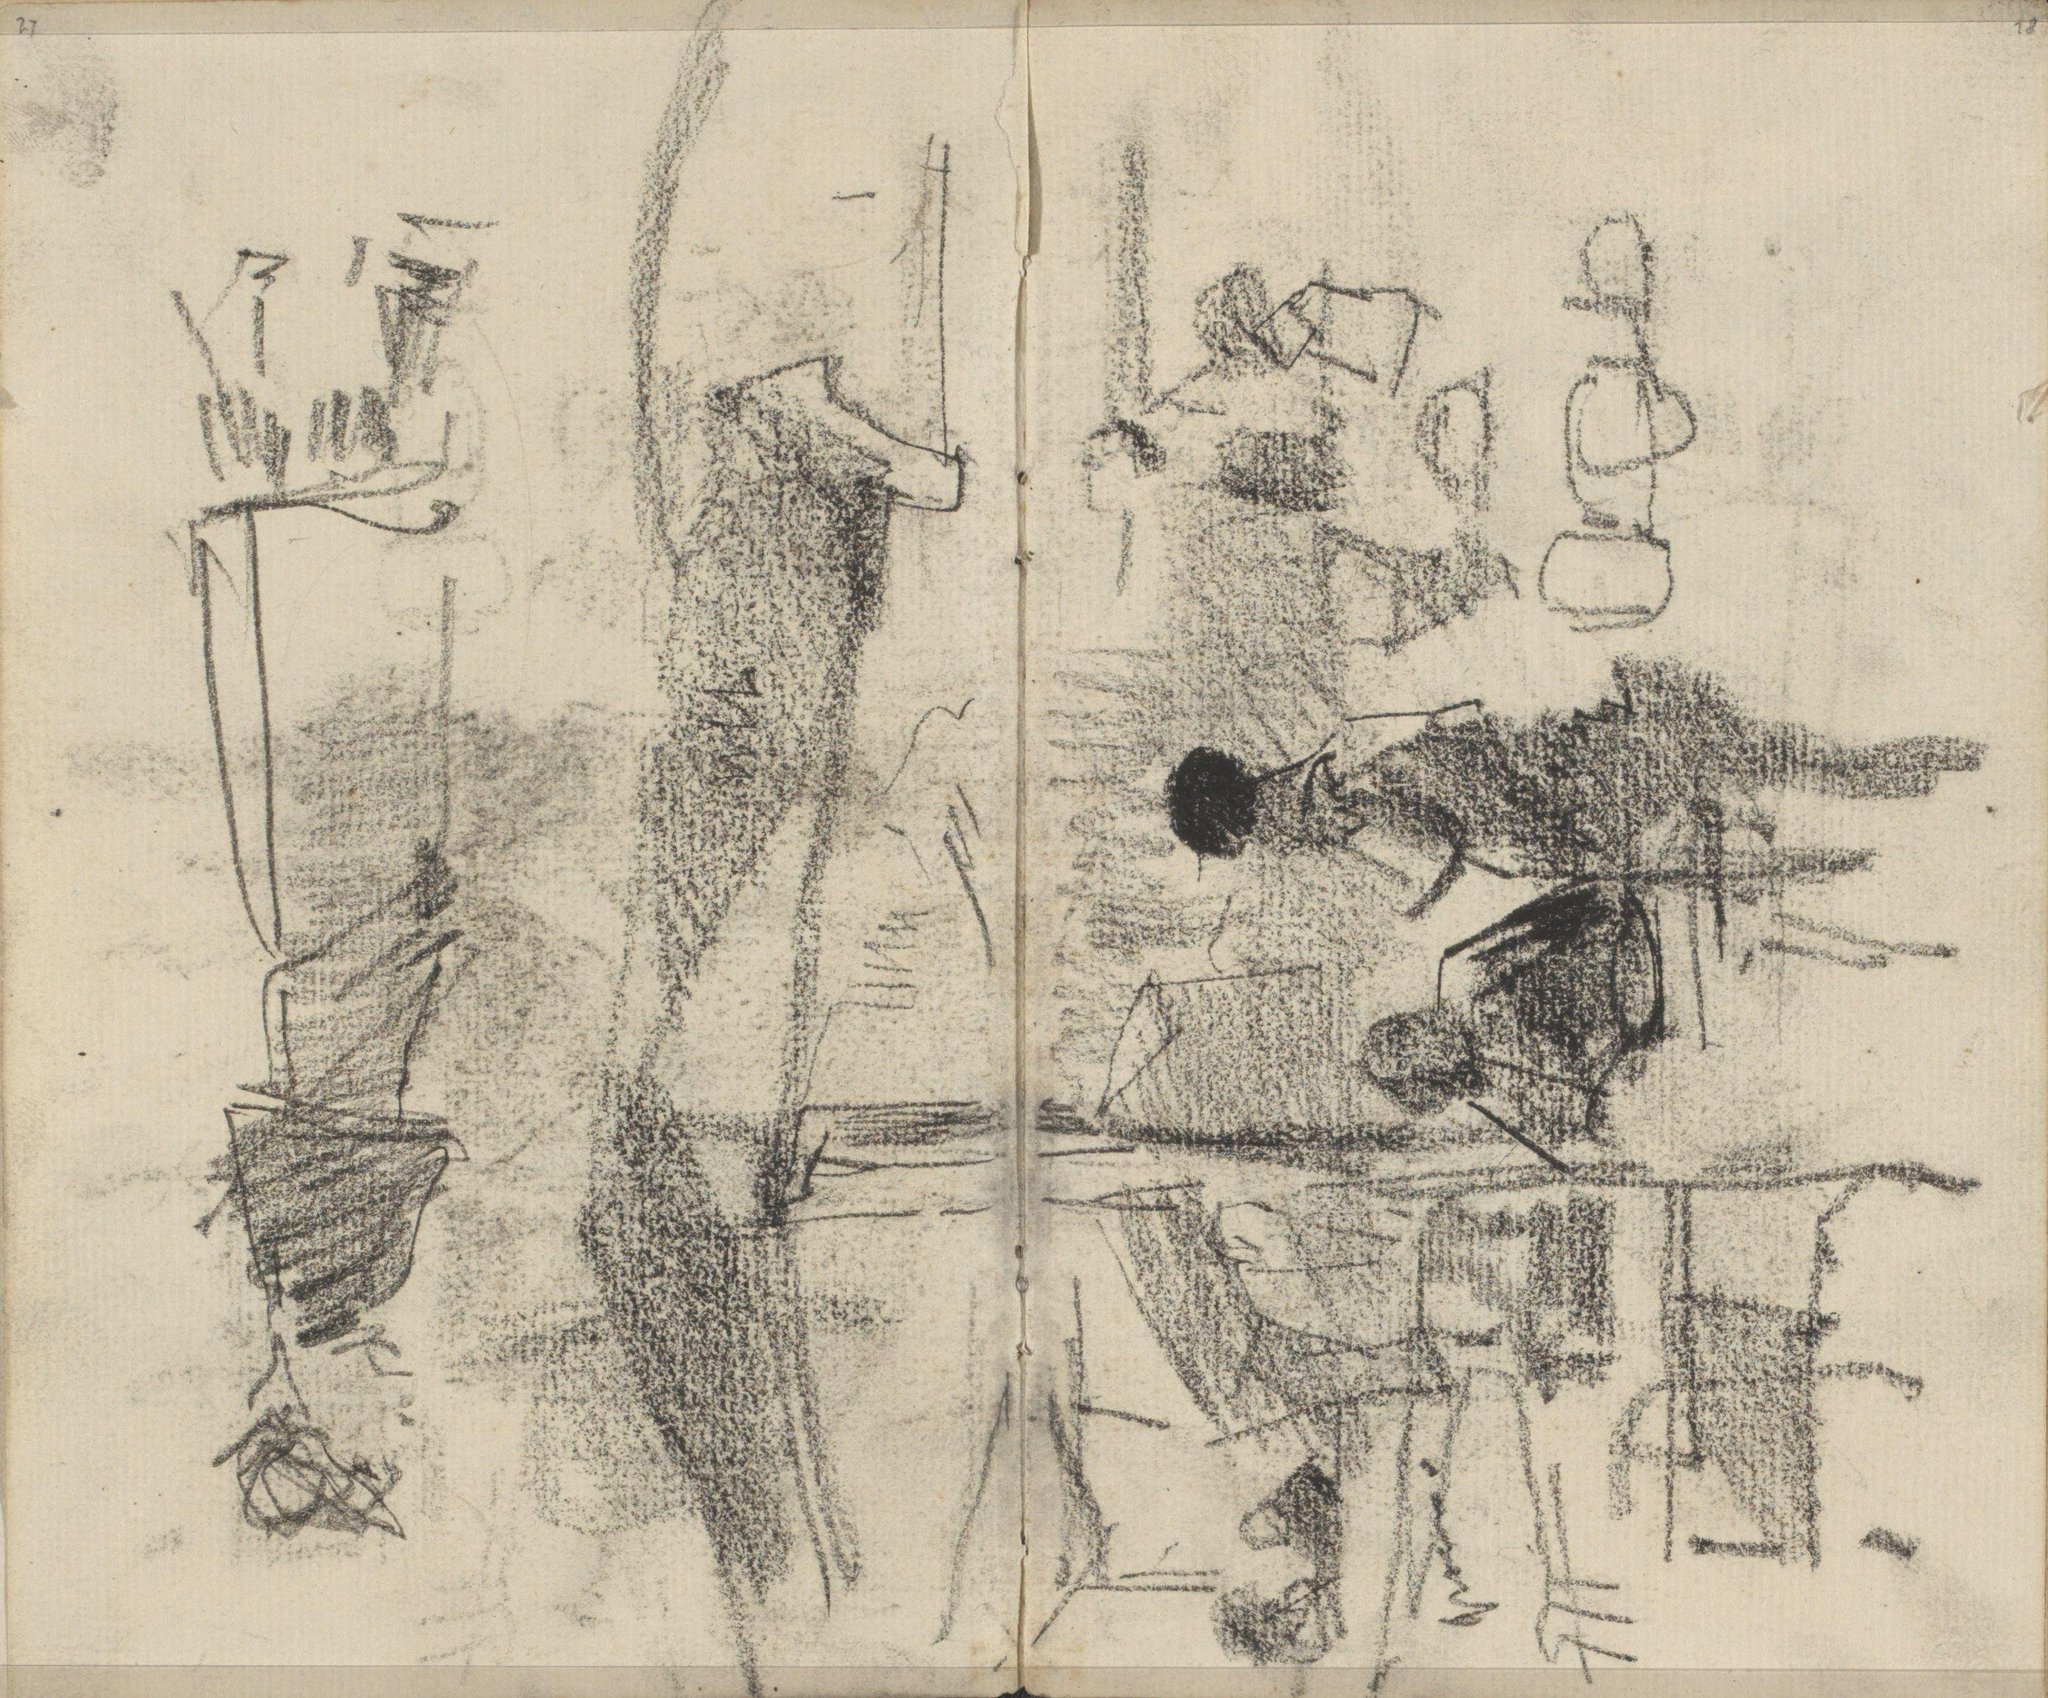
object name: sketchbook leaf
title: Figuren, mogelijk op een markt of in een etablissement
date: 1882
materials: chalk, paper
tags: standing figure - aa - female human figure (+ sideview, profile), inn, coffee-house, public house, etc.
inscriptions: kleurnotitie, handgeschreven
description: Links een staande vrouw. Pagina 27 en pagina 28 uit een schetsboek met 31 bladen vervaardigd te Den Haag en Rotterdam.